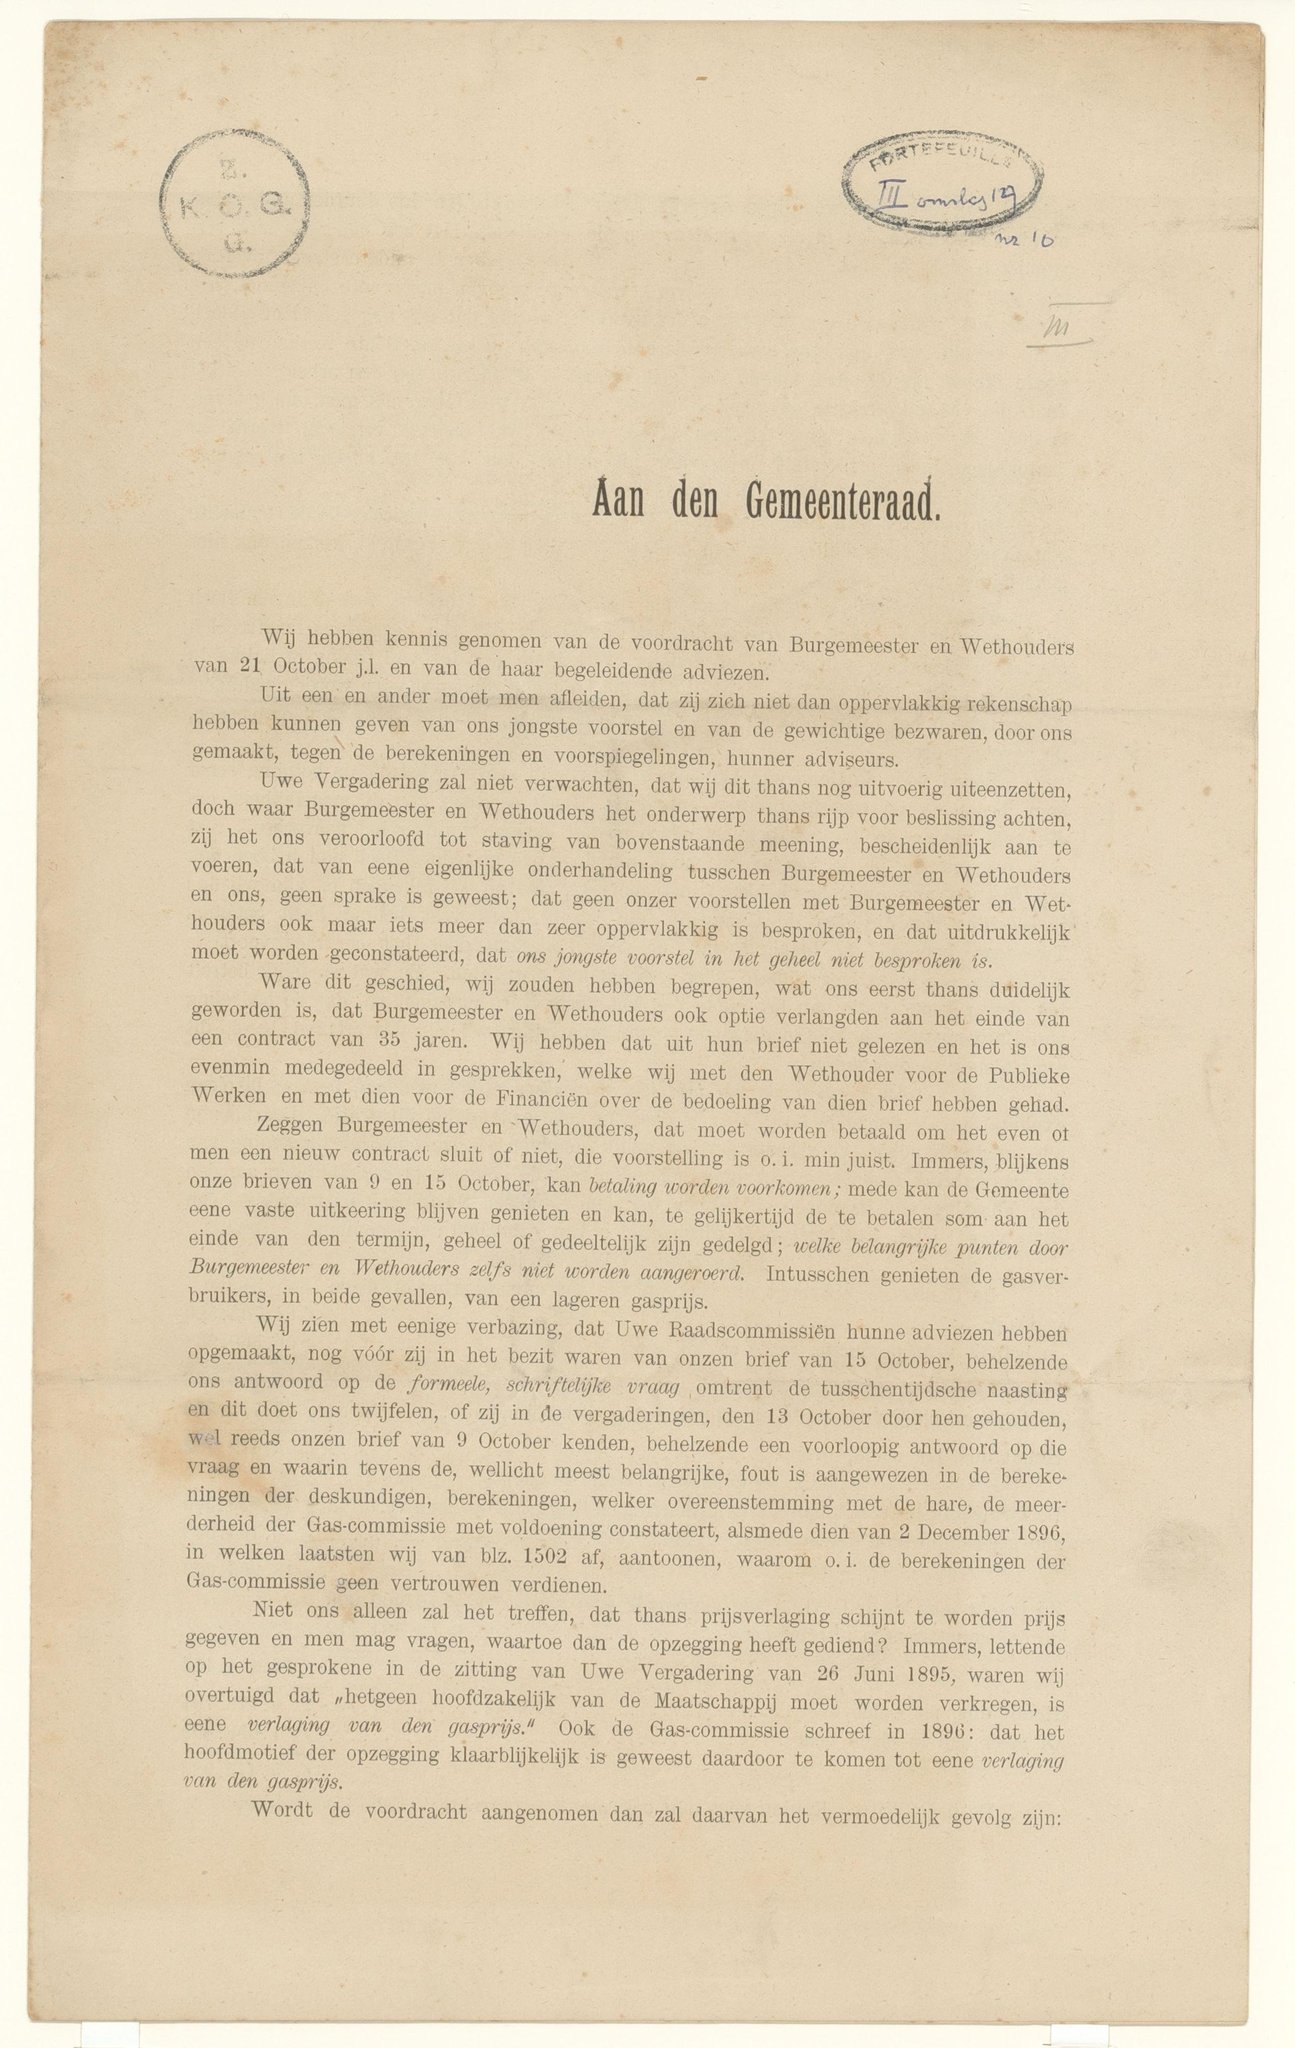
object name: text sheet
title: Brief aan de gemeenteraad van Amsterdam over het overnemen van de gasfabrieken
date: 1897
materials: paper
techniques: letterpress printing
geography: amsterdam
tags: gas extracted from coal, amsterdam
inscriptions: stamp, collector's mark: Lugt 1641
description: Brief aan de gemeenteraad van Amsterdam over het overnemen van de gasfabrieken van Imperial Continental Gas Associaton. Vierbladig tekstblad aan alle zijden bedrukt. Onderwerpsrubrieken binnen de Atlas Zeden en Gewoonten: Regeering, Telefoon, Gas, electriciteit.